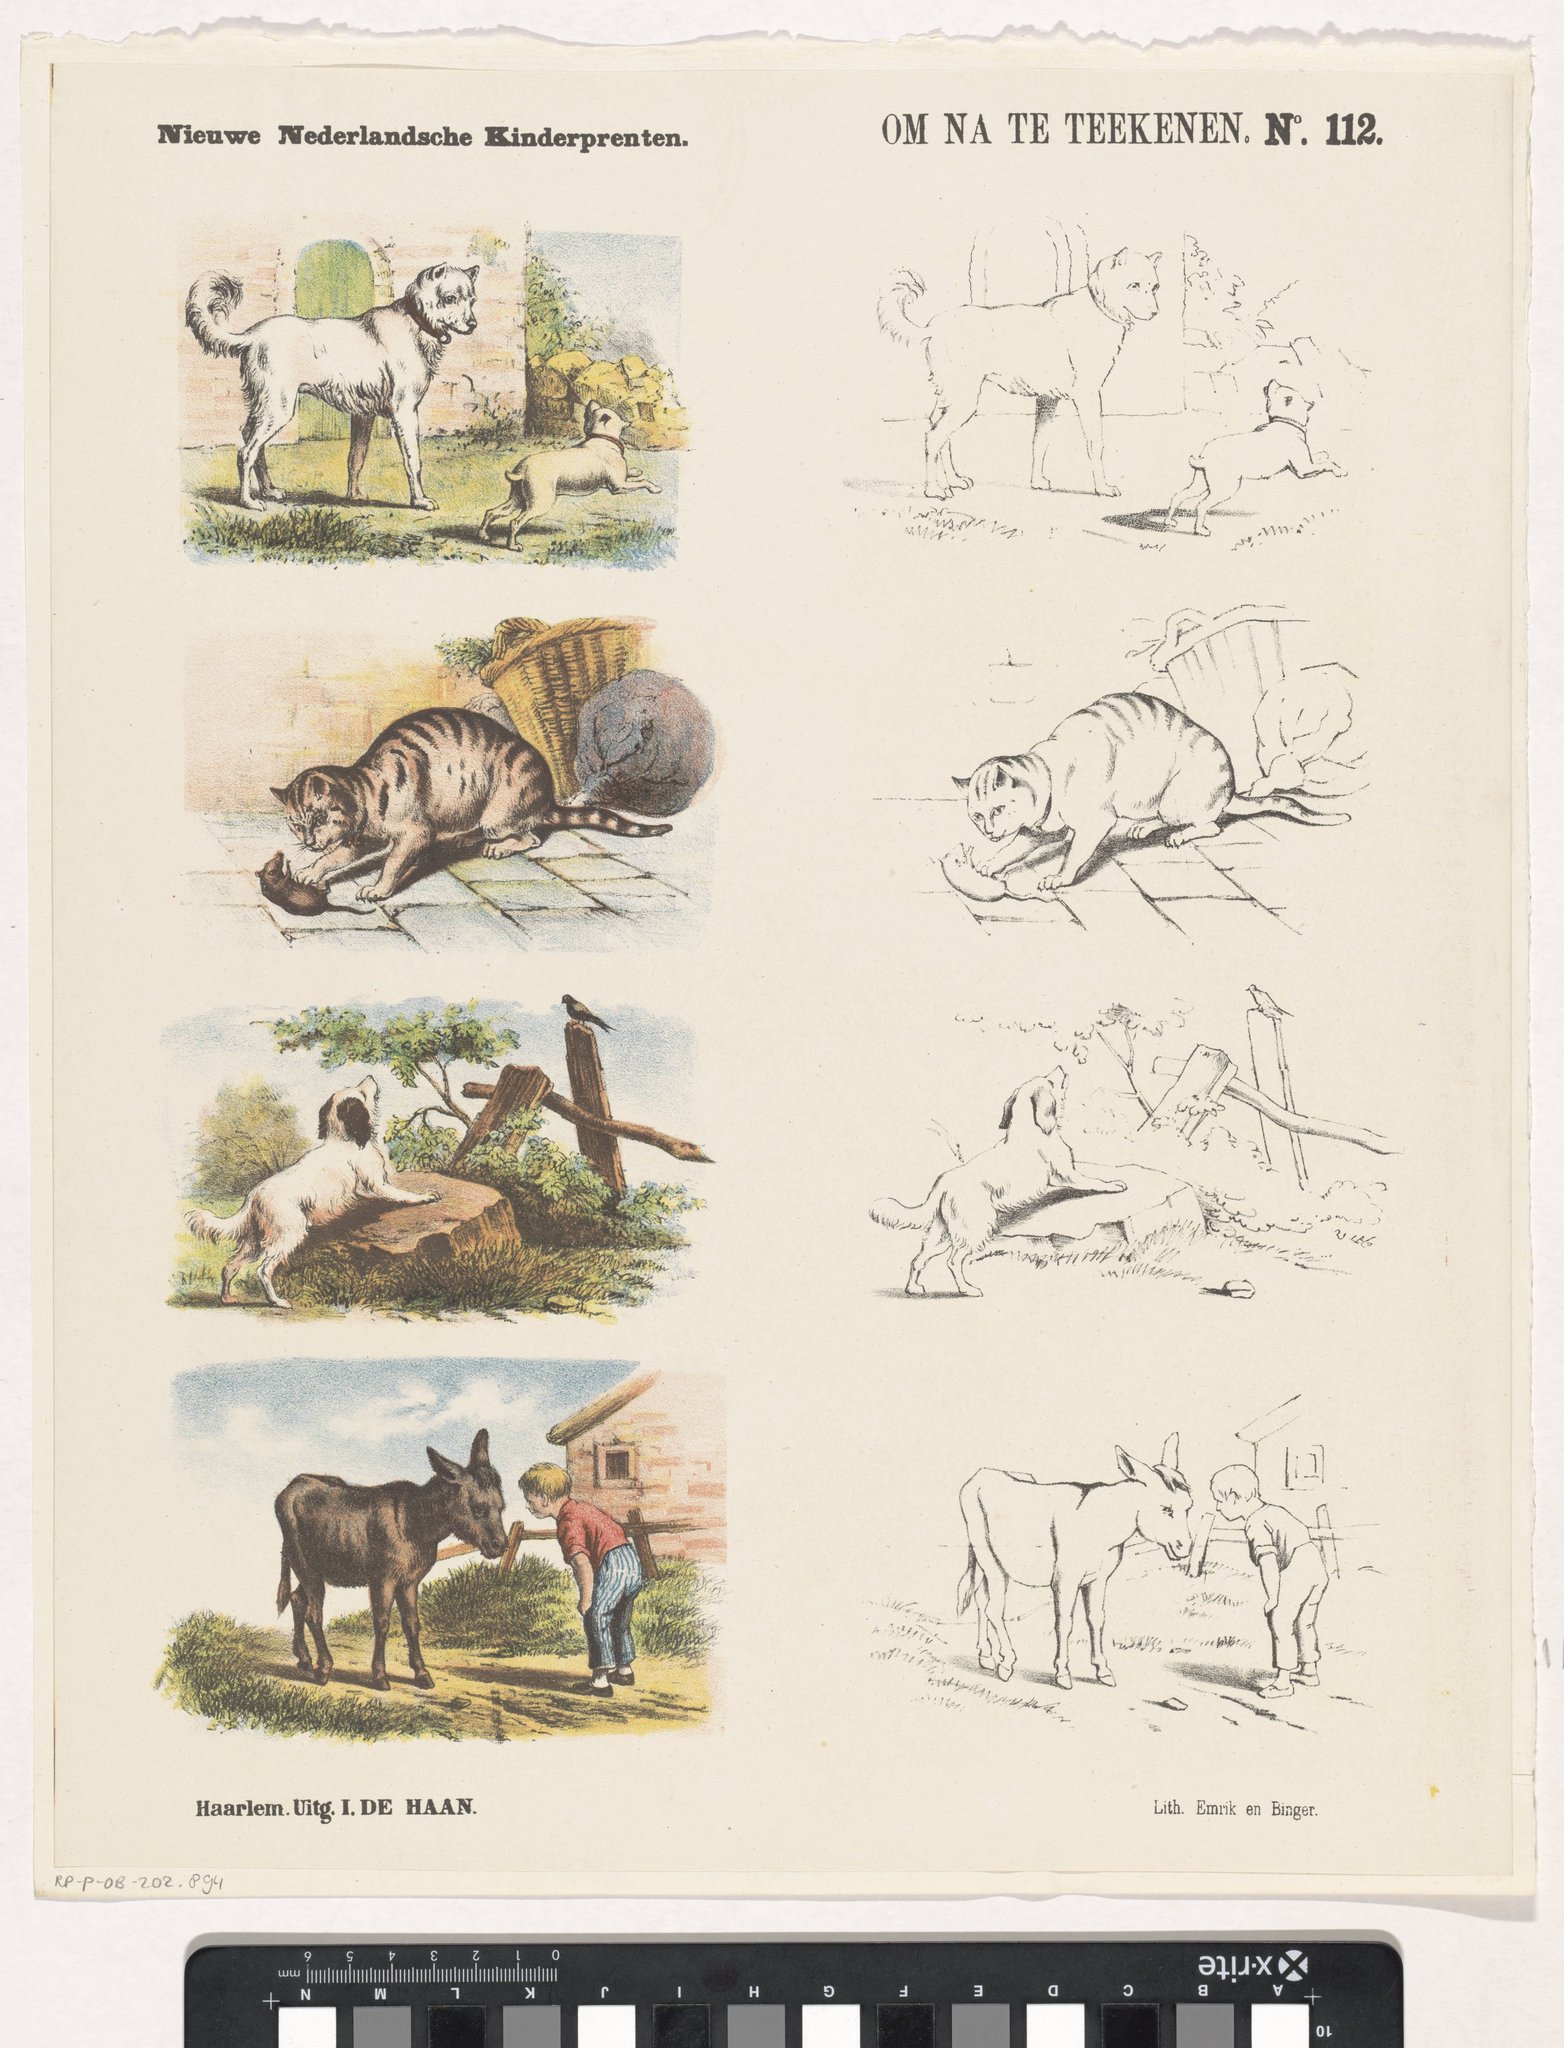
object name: print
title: Om na te teekenen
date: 1875-1903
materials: paper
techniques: lithograph, letterpress printing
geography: haarlem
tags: animals, ass, donkey, cat and mouse, dog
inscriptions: collector's mark: Lugt 2760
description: Blad met 8 voorstellingen van dieren. Links onder elkaar vier ingekleurde afbeeldingen van honden, een kat en een ezel. Rechts dezelfde vier afbeeldingen met enkel de contouren in zwart. Genummerd rechtsboven: No. 112.